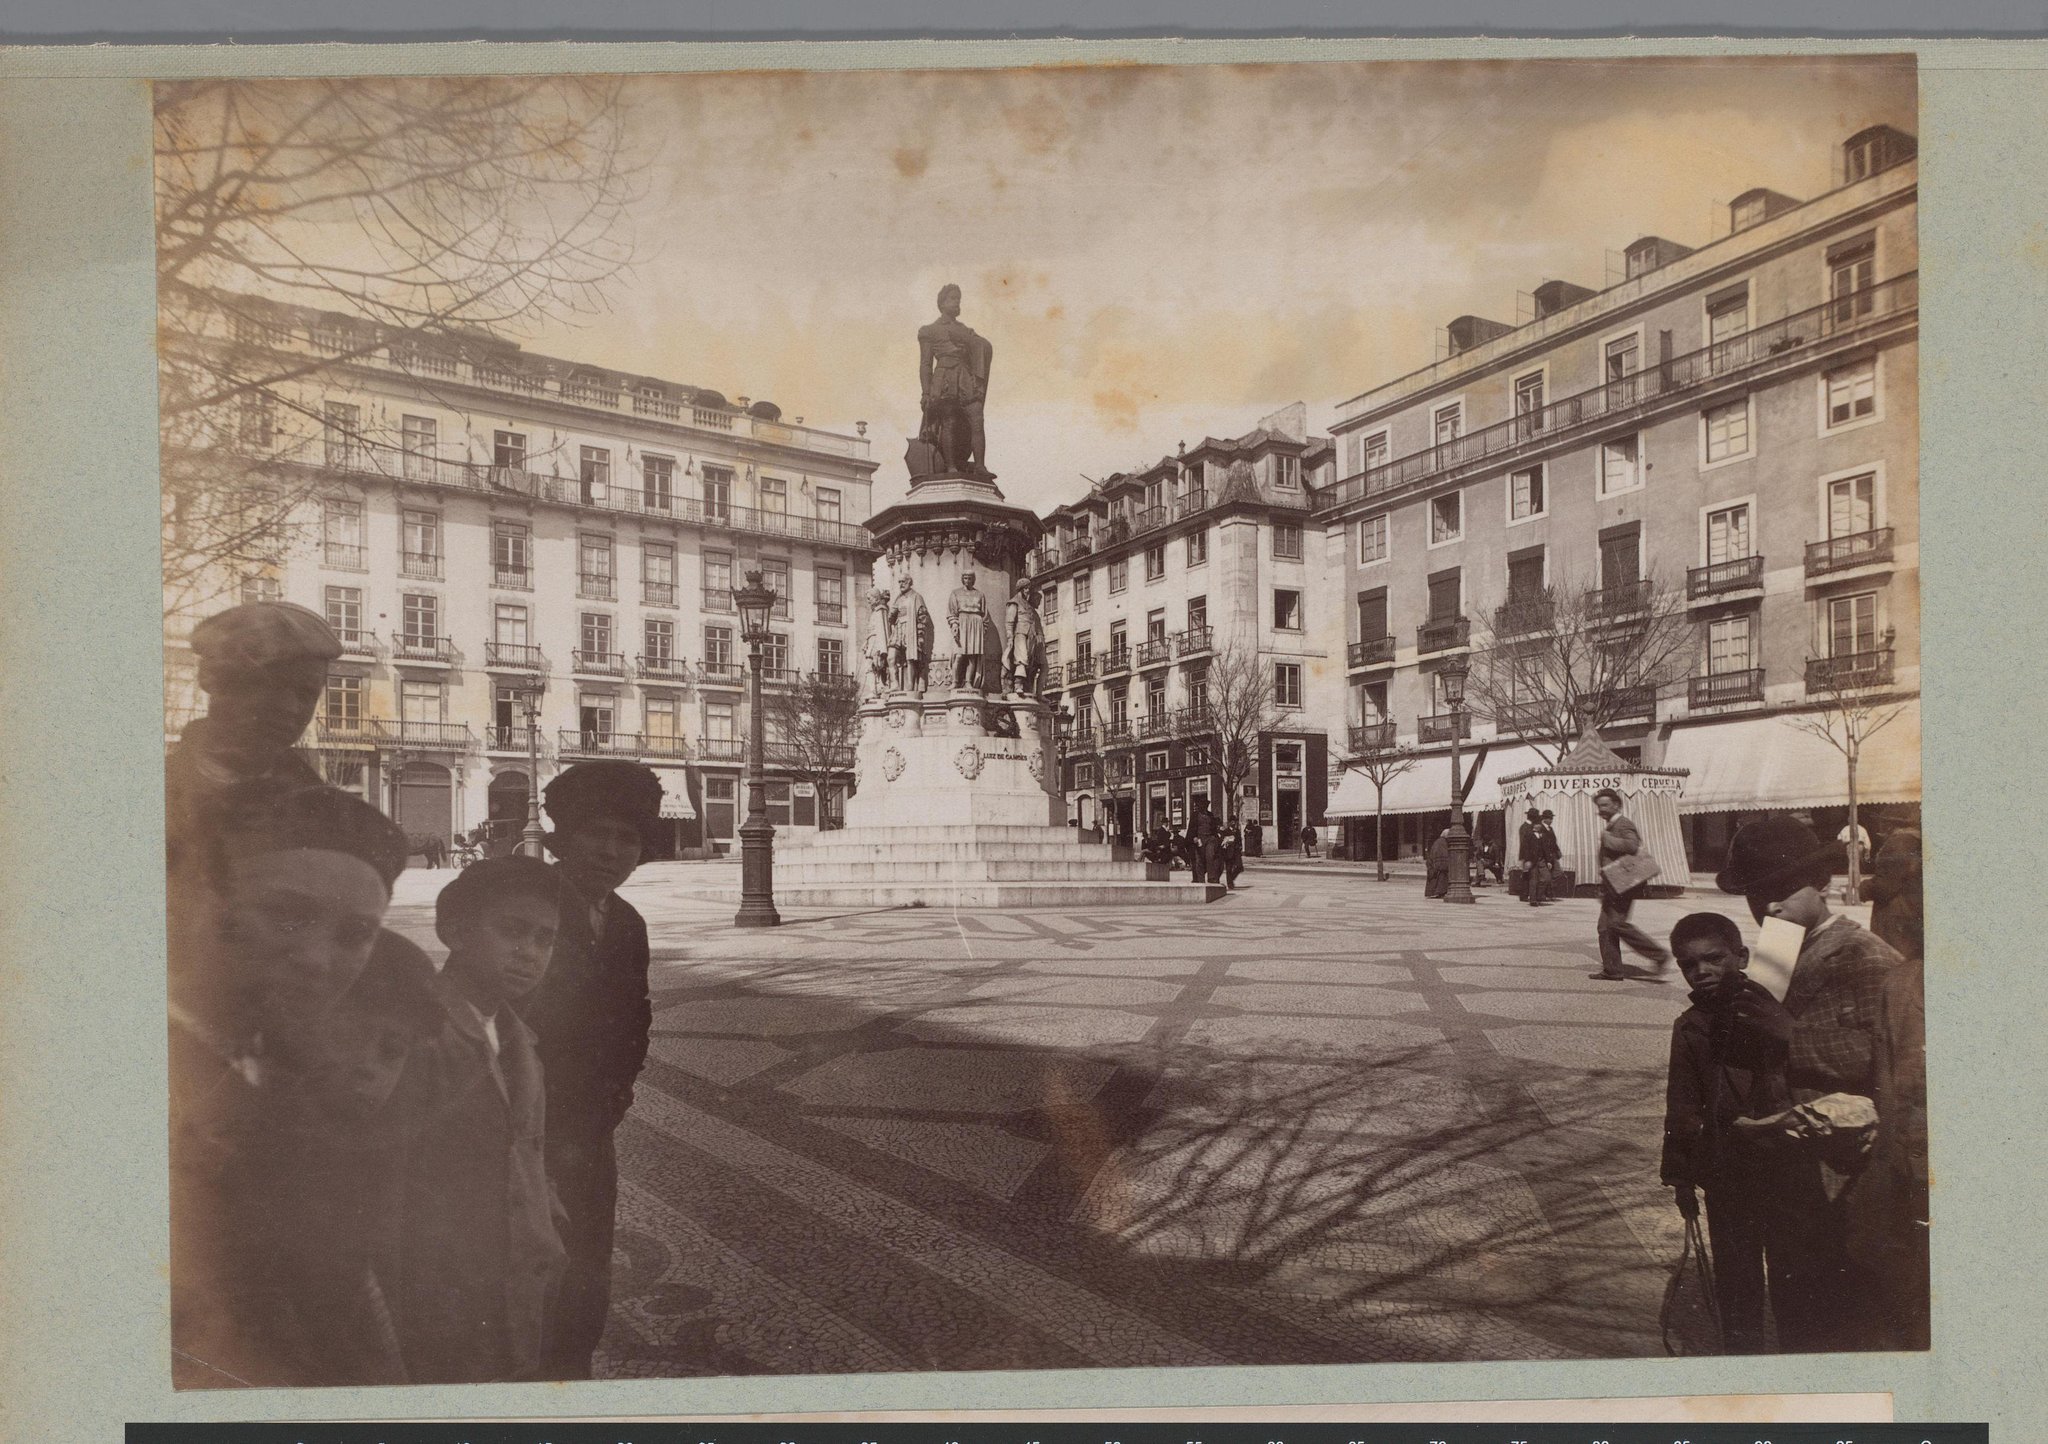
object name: photograph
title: Praça de Camoes en Praça de Don Pedro, Lissabon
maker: Anonymous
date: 1860-1900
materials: cardboard, paper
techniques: albumen print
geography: lisbon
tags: square, place, circus, etc.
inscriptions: inscription: ‘(5 Juni - 20 Juni)’